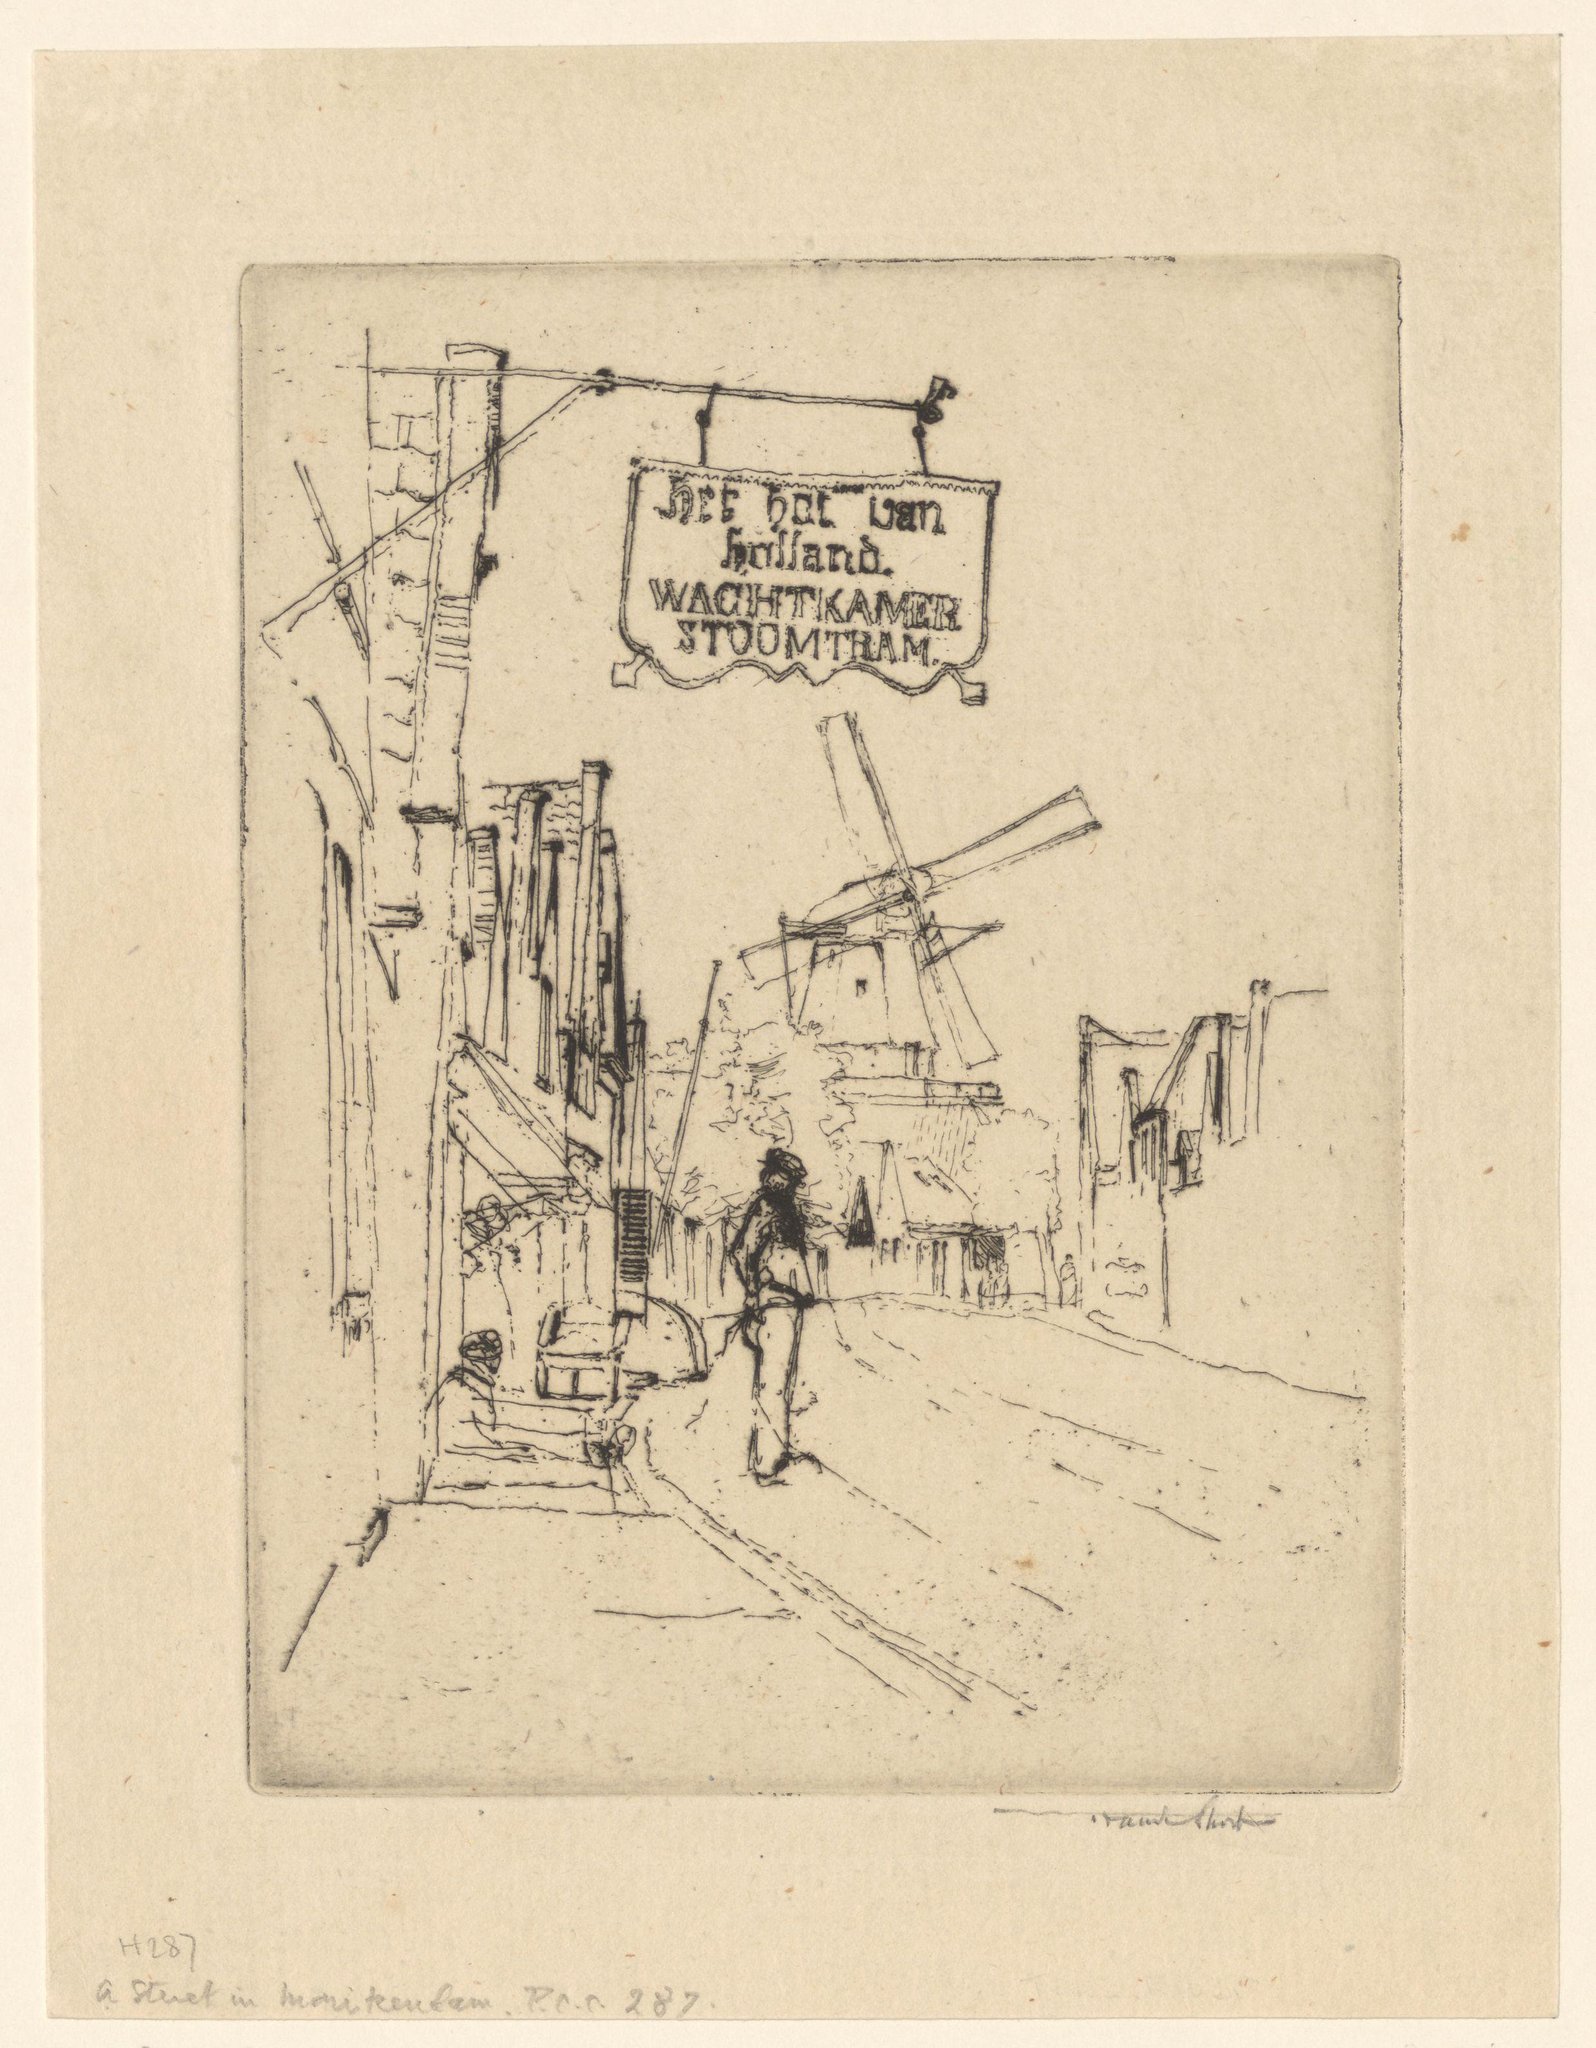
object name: print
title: Gezicht op een straat in Monnickendam met windmolen en wachtkamer voor stoomtram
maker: frank short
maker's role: print maker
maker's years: 1857-1945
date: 1892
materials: paper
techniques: etching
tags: waiting room (railway, tramway), windmill, street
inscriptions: collector's mark: Lugt 2760, signature: ‘Frank Short’, collector's mark: Lugt 2228